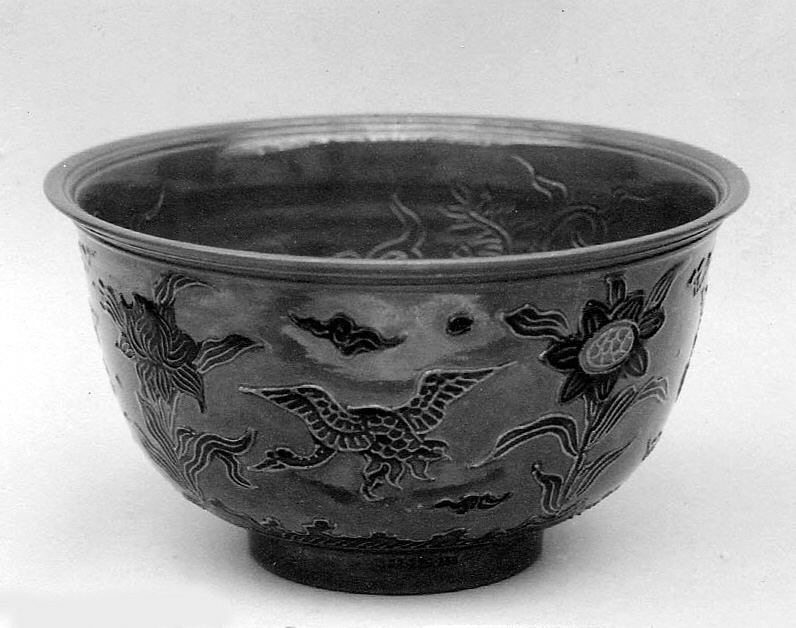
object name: bowl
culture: japanese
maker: eiraku hozen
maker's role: artist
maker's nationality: japanese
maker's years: 1795-1854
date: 1800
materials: enamel, porcelain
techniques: glazing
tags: flowers